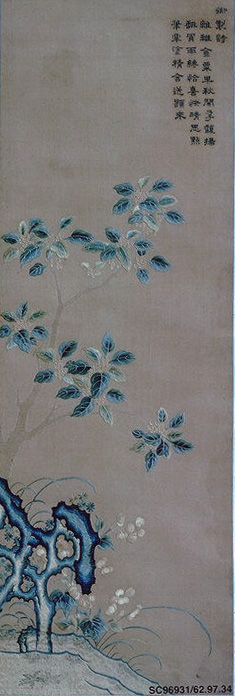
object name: panel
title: Begonia and Rock Representing Winter; from Set of Four Panels Representing the Four Seasons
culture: chinese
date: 1701-1800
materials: paint, silk